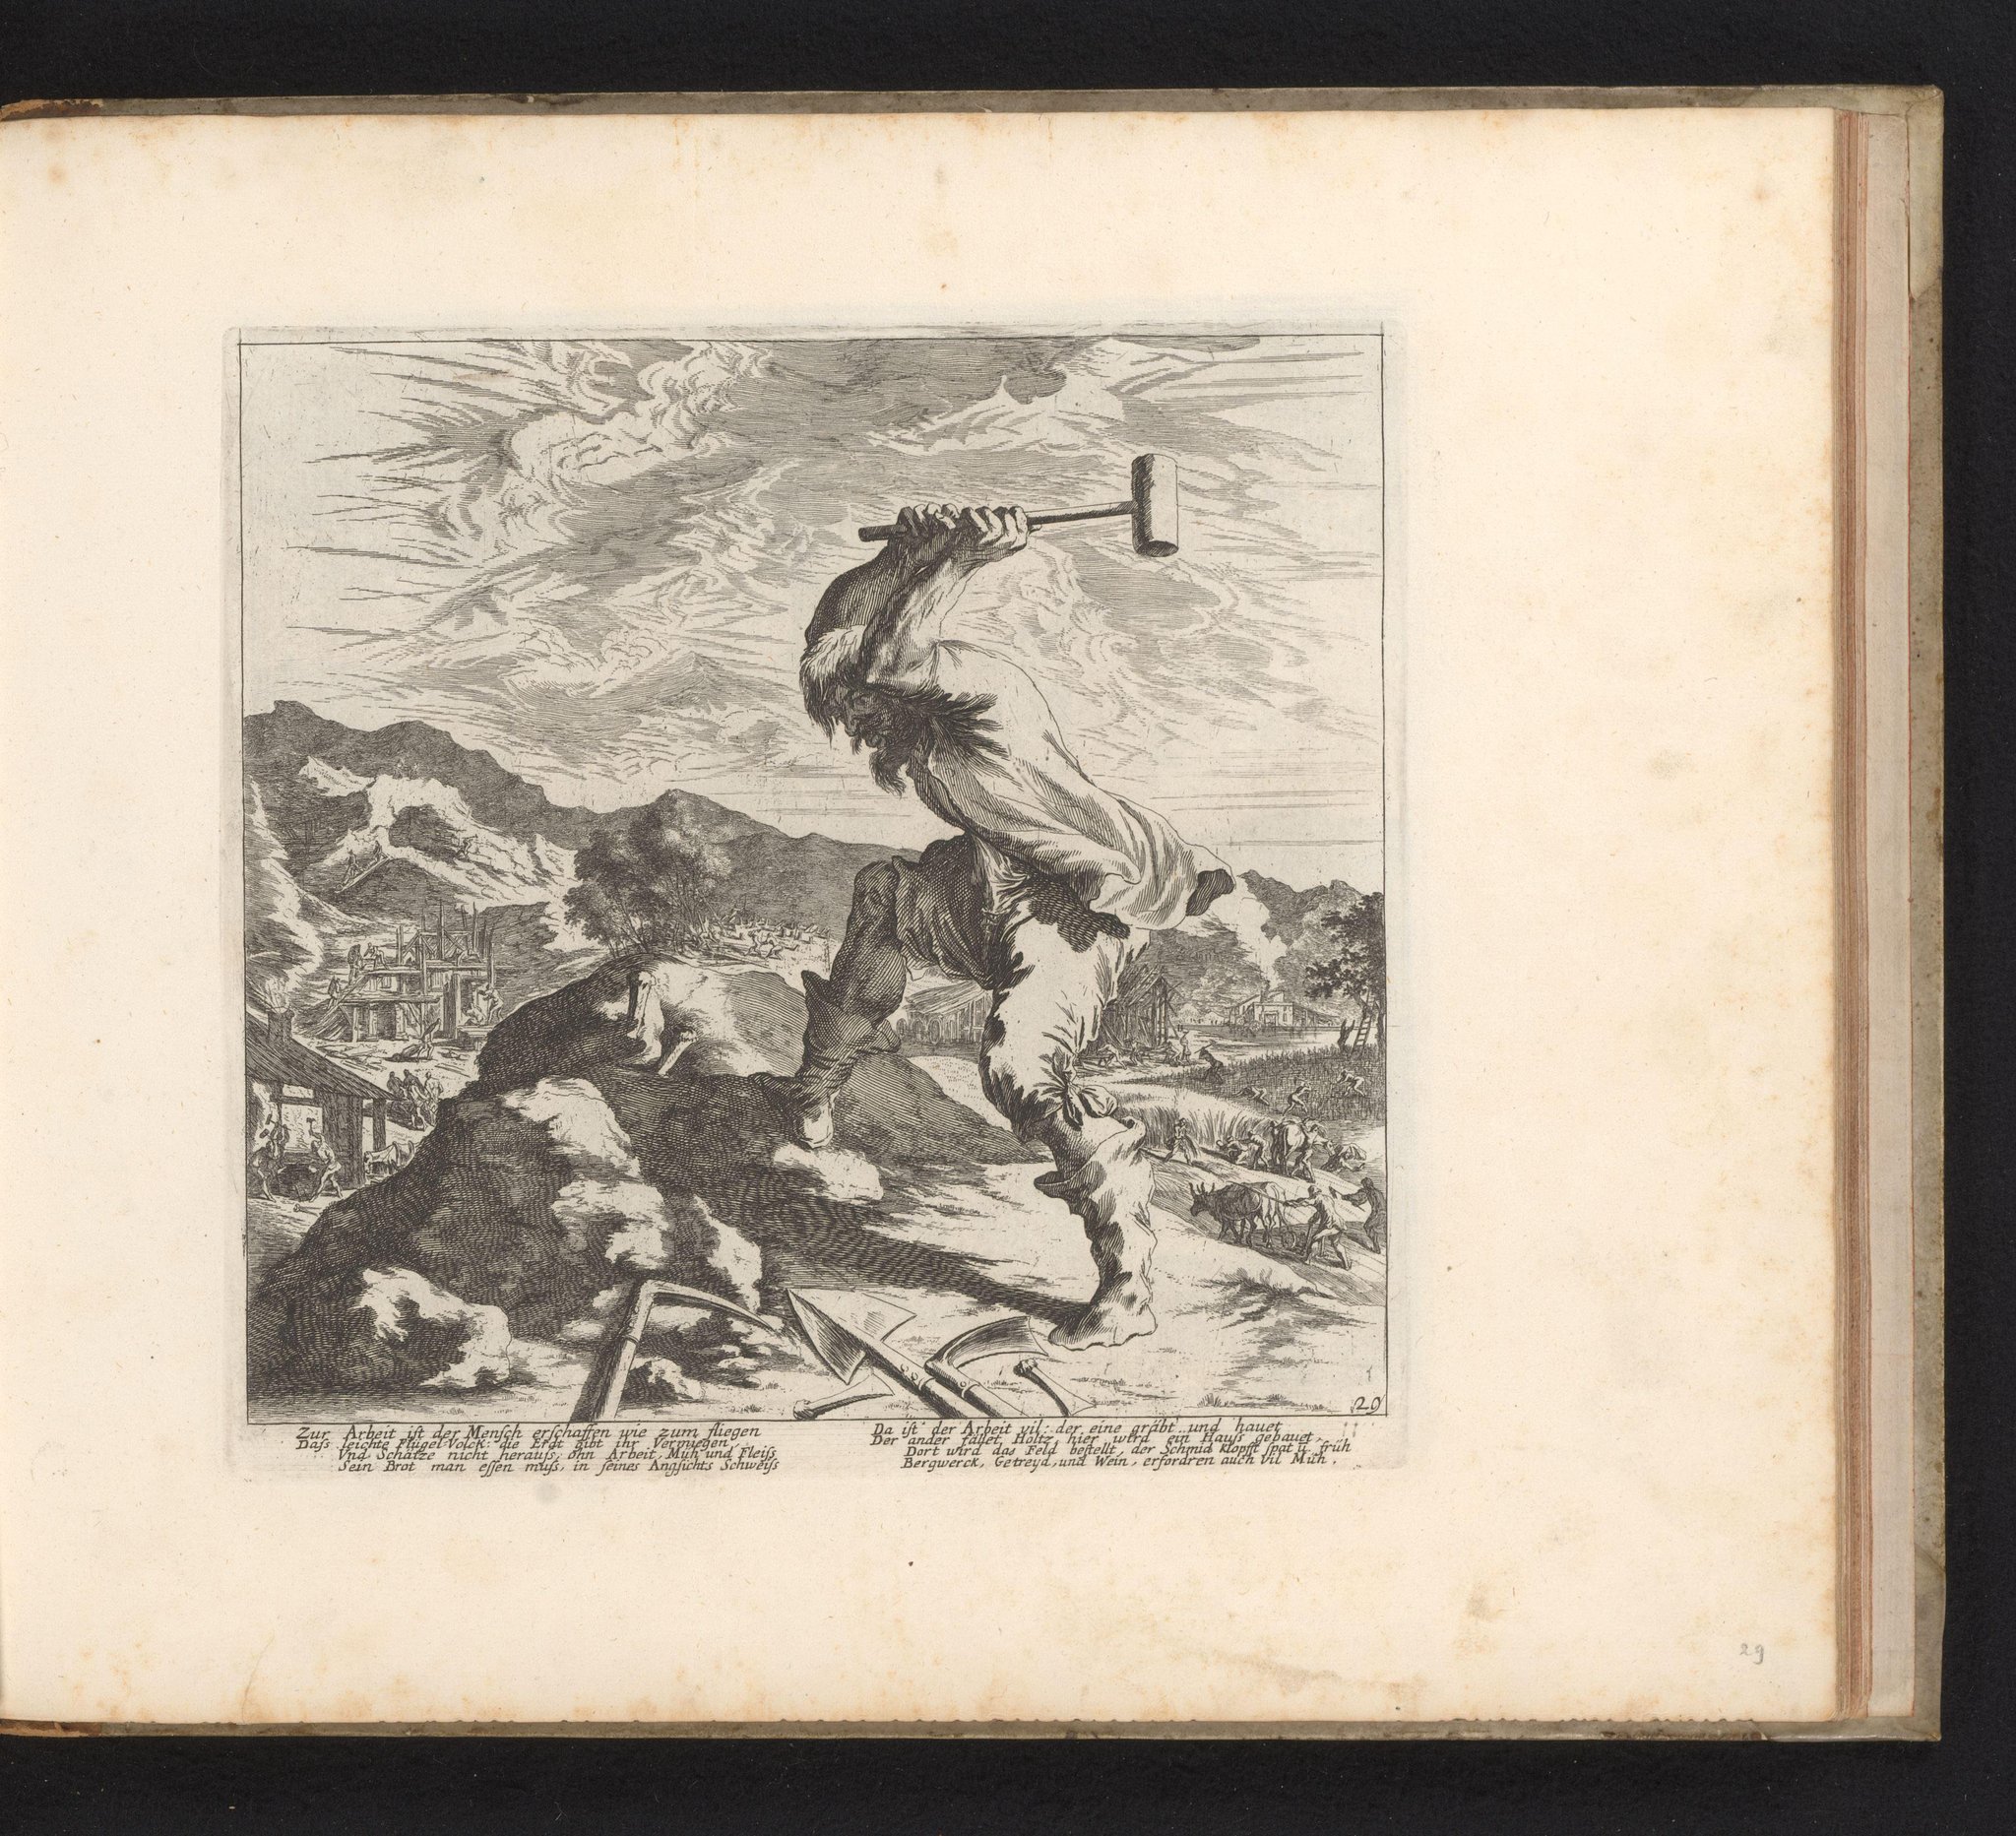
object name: print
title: Personificatie van Arbeid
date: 1670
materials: paper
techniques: etching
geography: augsburg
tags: labour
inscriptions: collector's mark: Lugt 2228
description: Deze prent hoort bij een reeks (RP-P-1963-360 t/m RP-P-1963-372) van allegorische figuren, deugden en ondeugden in het album: Johann Wilhelm Baur, Iconographia, 1682.